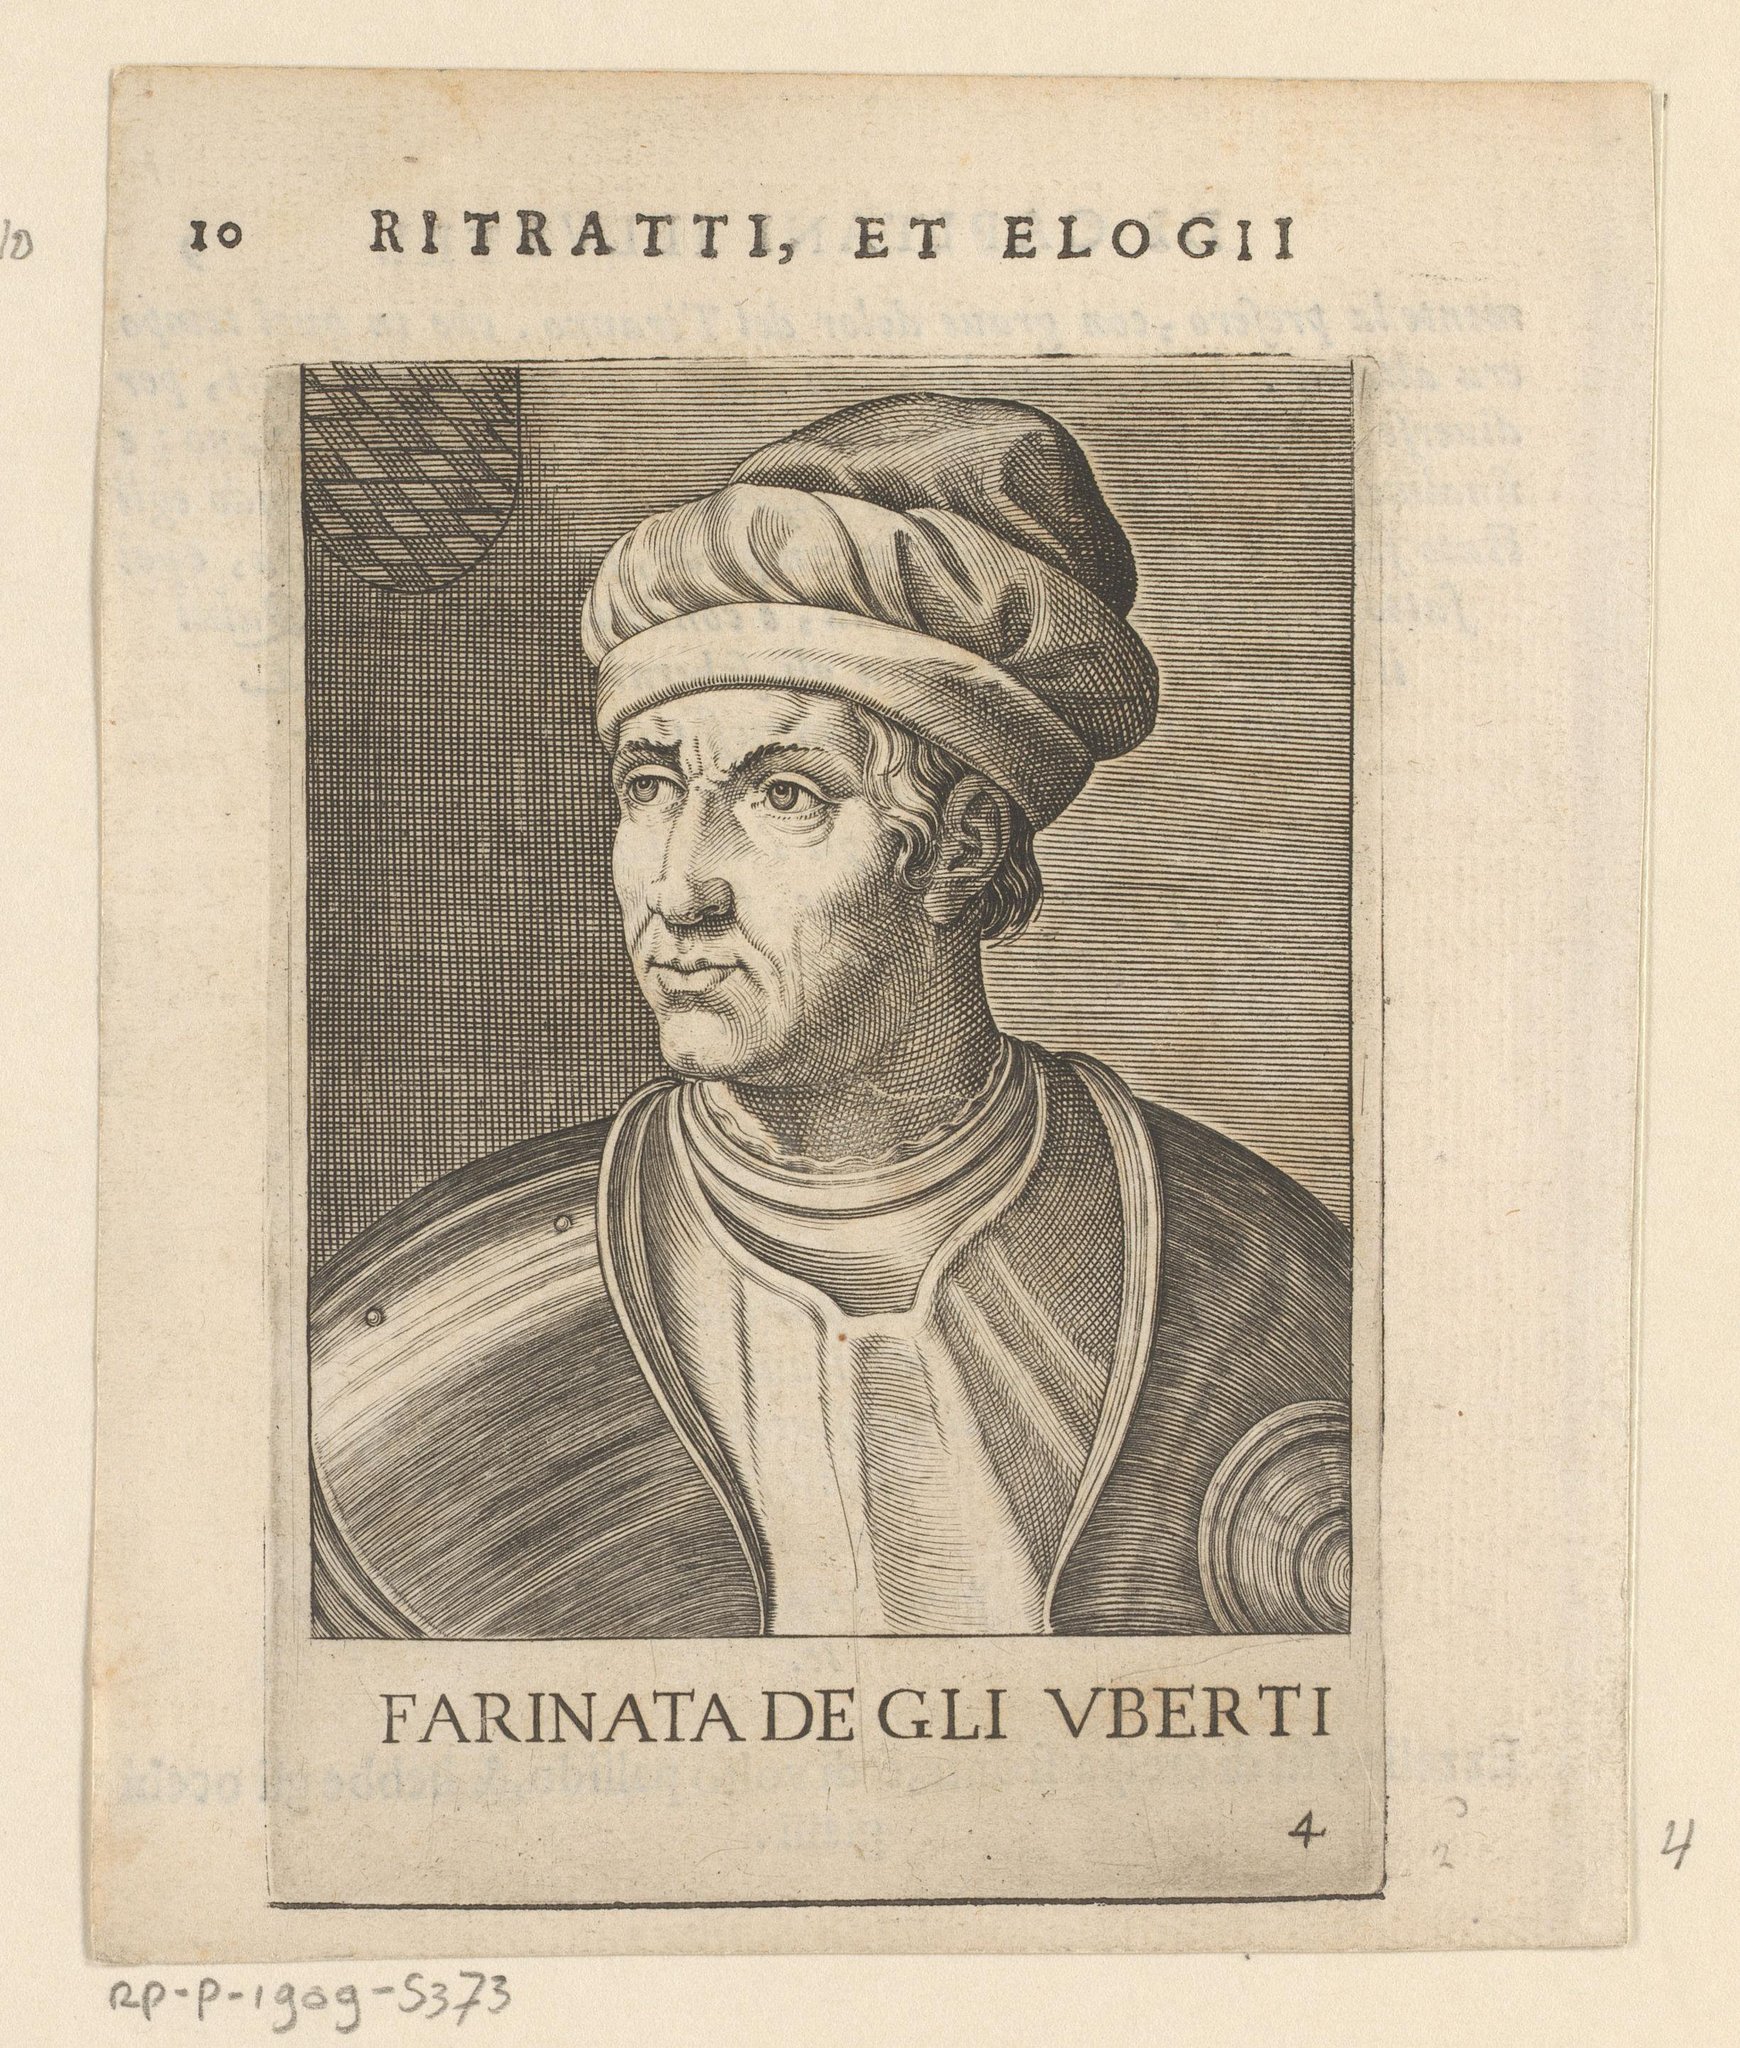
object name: print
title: Farinata degli Uberti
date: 1635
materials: paper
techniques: engraving, letterpress printing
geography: rome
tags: commander-in-chief, general, marshal, historical persons, armorial bearing, heraldry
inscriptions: collector's mark: Lugt 2228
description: Prent uit: Ritratti et elogii di capitani Illustri. Rome: Pompilio Totti en Andrea Fei, 1635, p. 10. Eerdere staat van prent in ieder geval ook gebruikt in: Ritratti di cento capitani illustri con li lor Fatti in guerra (…), Rome: Domenico Gigliotti, 1596. Latere staat van prent in ieder geval ook gebruikt in: Ritratti et elogii di capitani Illustri. Che ne'secoli moderni hanno gloriosamente guerreggiato. Rome: Filippo de'Rossi en Vitale Mascardi, 1646.